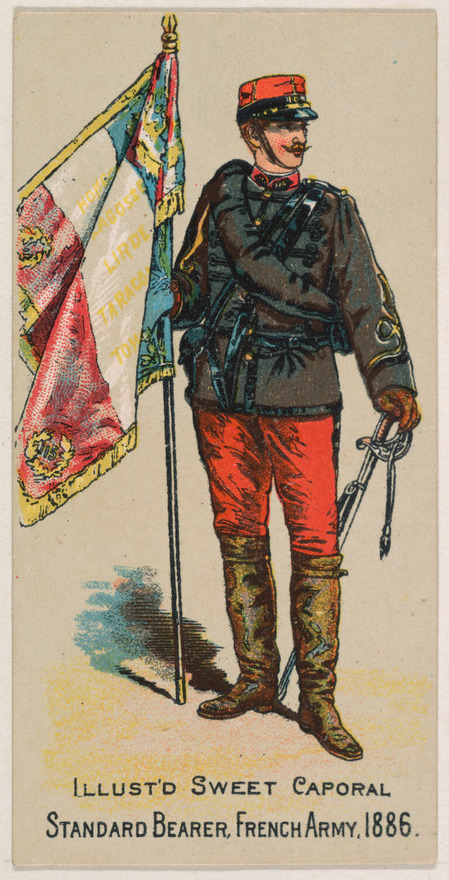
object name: print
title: Standard Bearer, French Army, 1886, from the Military Series (N224) issued by Kinney Tobacco Company to promote Sweet Caporal Cigarettes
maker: kinney brothers tobacco company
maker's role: publisher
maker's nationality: american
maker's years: 1869-2011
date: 1888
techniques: color lithograph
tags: military,men,flags